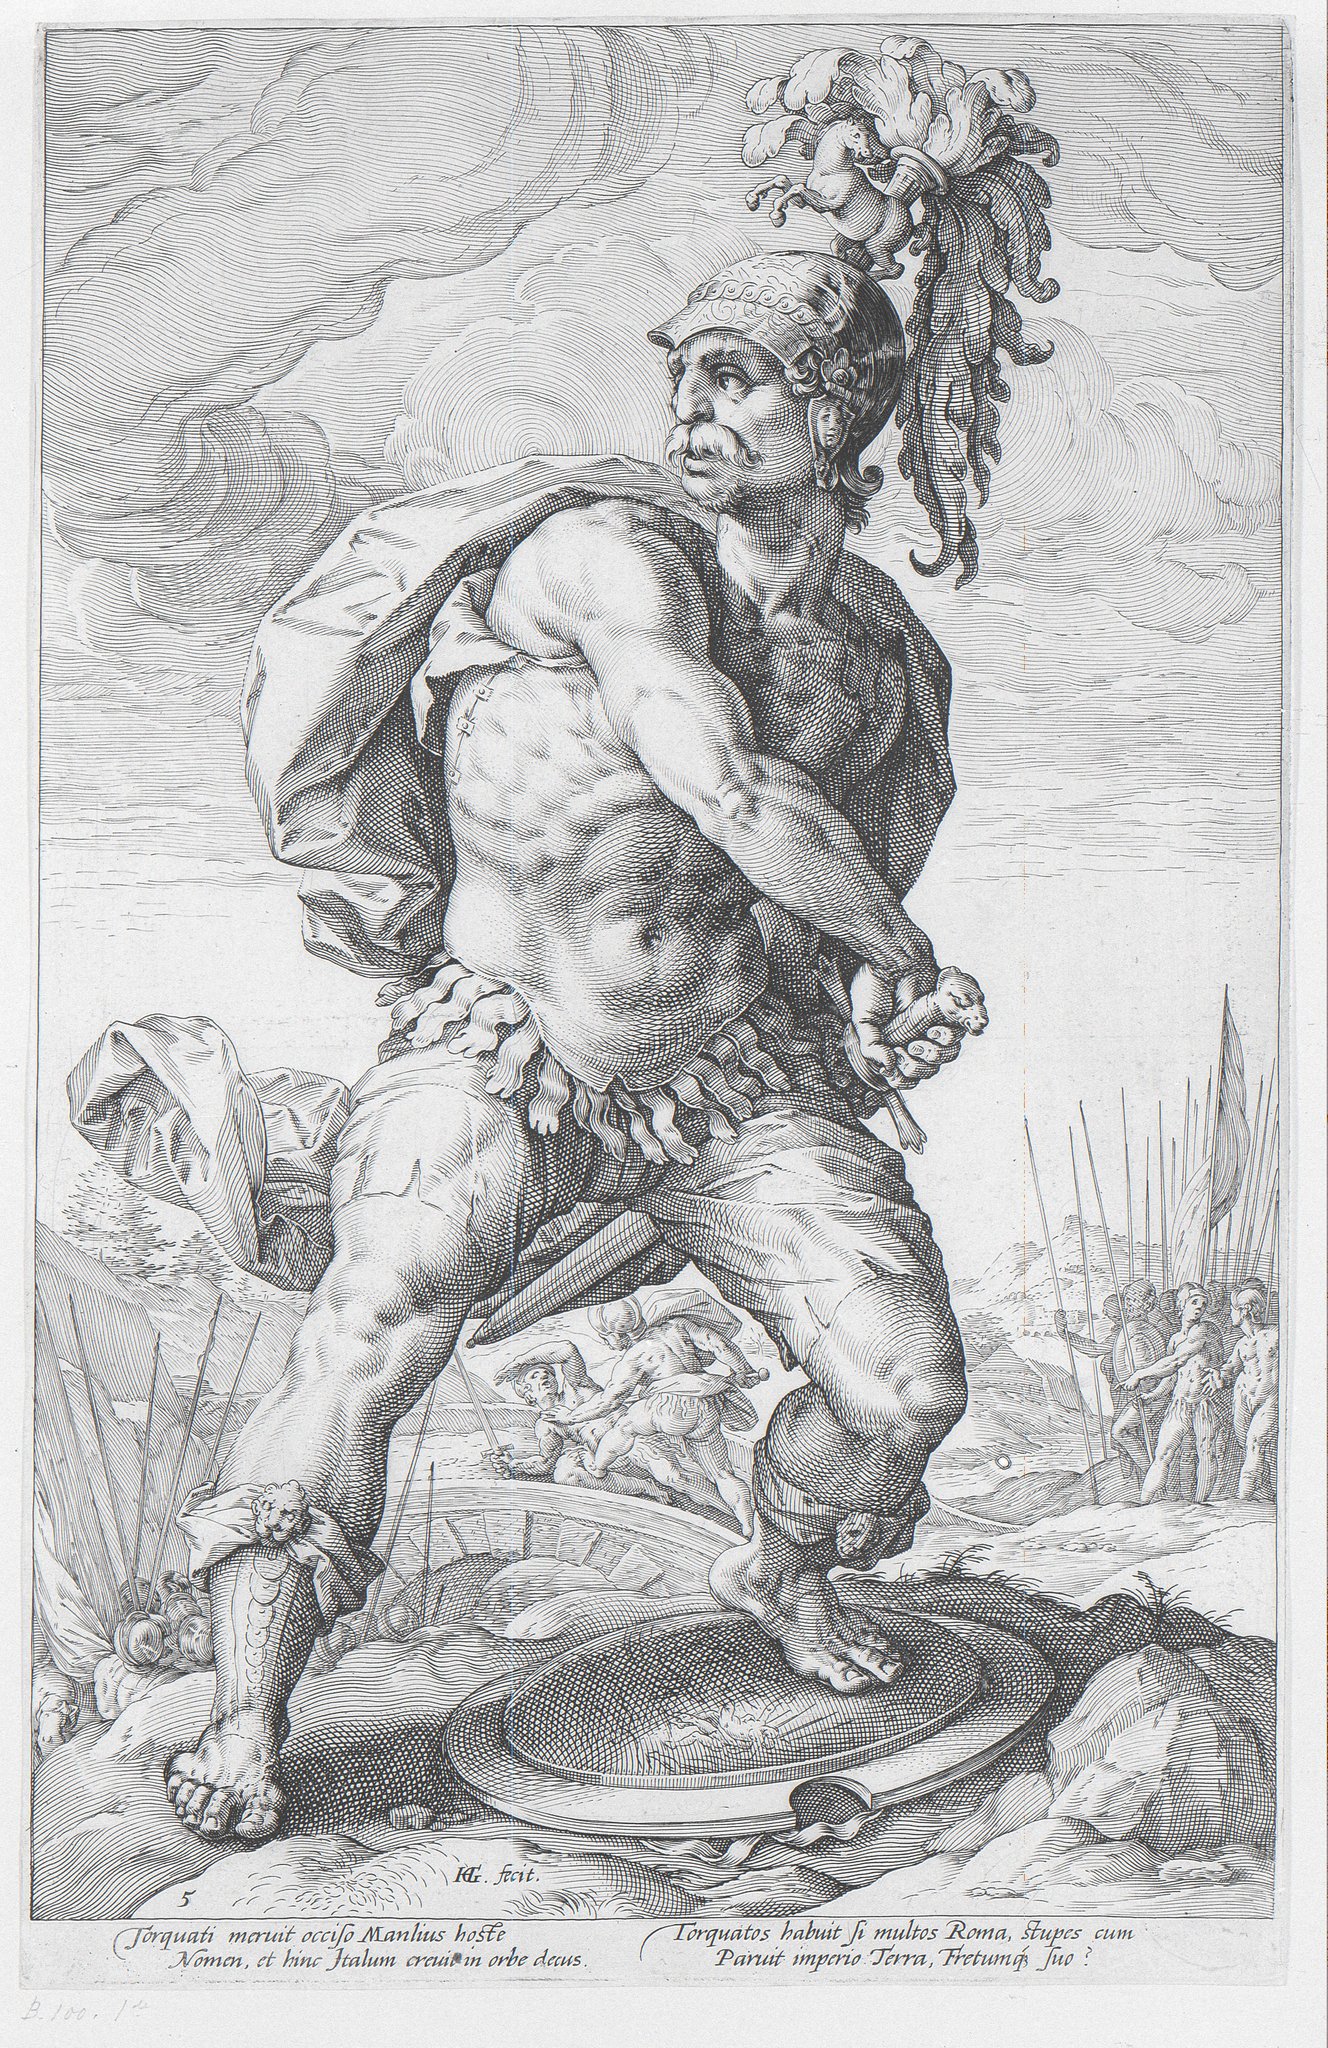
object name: print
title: Titus Manlius Torquatus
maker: hendrick goltzius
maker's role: draughtsman, painter, print maker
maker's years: 1558-1617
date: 1586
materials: paper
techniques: engraving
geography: haarlem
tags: titus manlius torquatus defeats in single combat a gigantic gaul and takes from him his golden neck-chain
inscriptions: collector's mark: Lugt 240, signature: ‘HG. fecit.’, caption: ‘Torquati meruit...Fretumq suo?’, number: ‘5’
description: De held Titus Manlius Torquatus ten voeten uit, terwijl hij zijn zwaard uit de schede trekt. Op de achtergrond is te zien hoe hij op een brug een Galliër verslaat. Onder de voorstelling twee maal twee versregels in Latijn. Deze prent is onderdeel van een serie van tien prenten, bestaand uit een ongenummerde titelprent, acht genummerde voorstellingen van helden en een ongenummerde afsluitende prent.